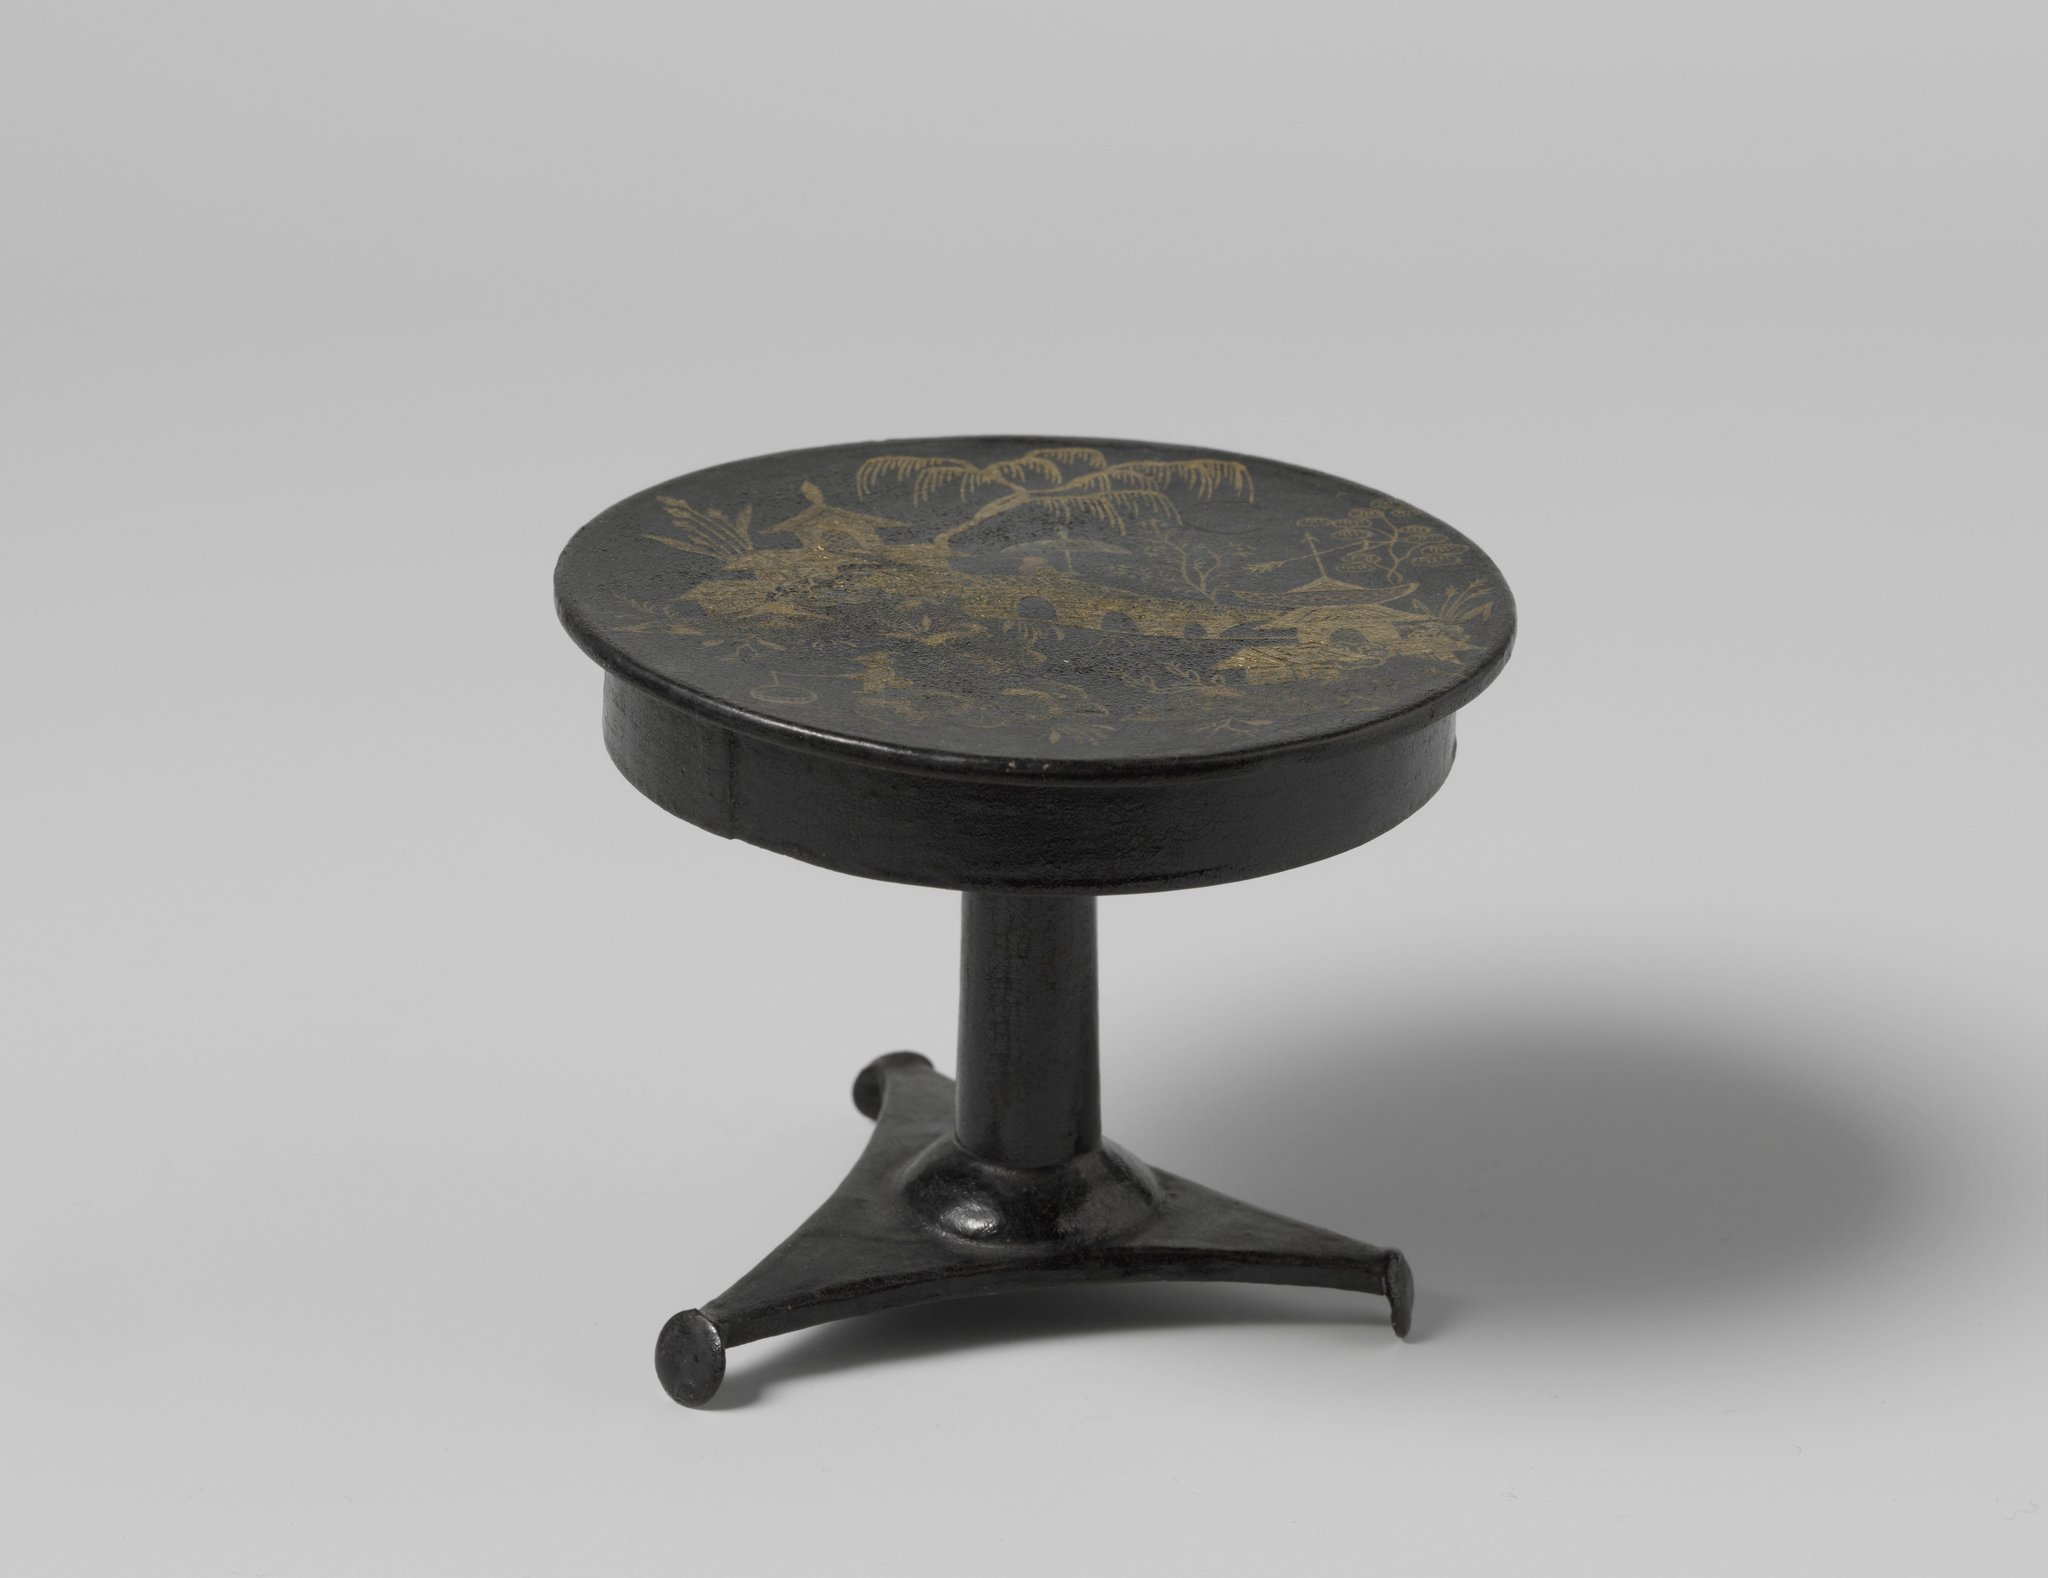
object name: miniature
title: Tafel met rond blad, zwartgelakt, met landschap in goud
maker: Anonymous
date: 1800-1849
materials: metal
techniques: lacquer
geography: amsterdam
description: Een tafel van zwartgelakte blik met rond blad, waarop licht- en donkergoudkleurig Oosters tafereel met landschap, huizen en twee figuren (imitatie-lakwerk); brede onderregel op kolompoot op drievoet, steunend op drie verticaal geplaatste schijven.